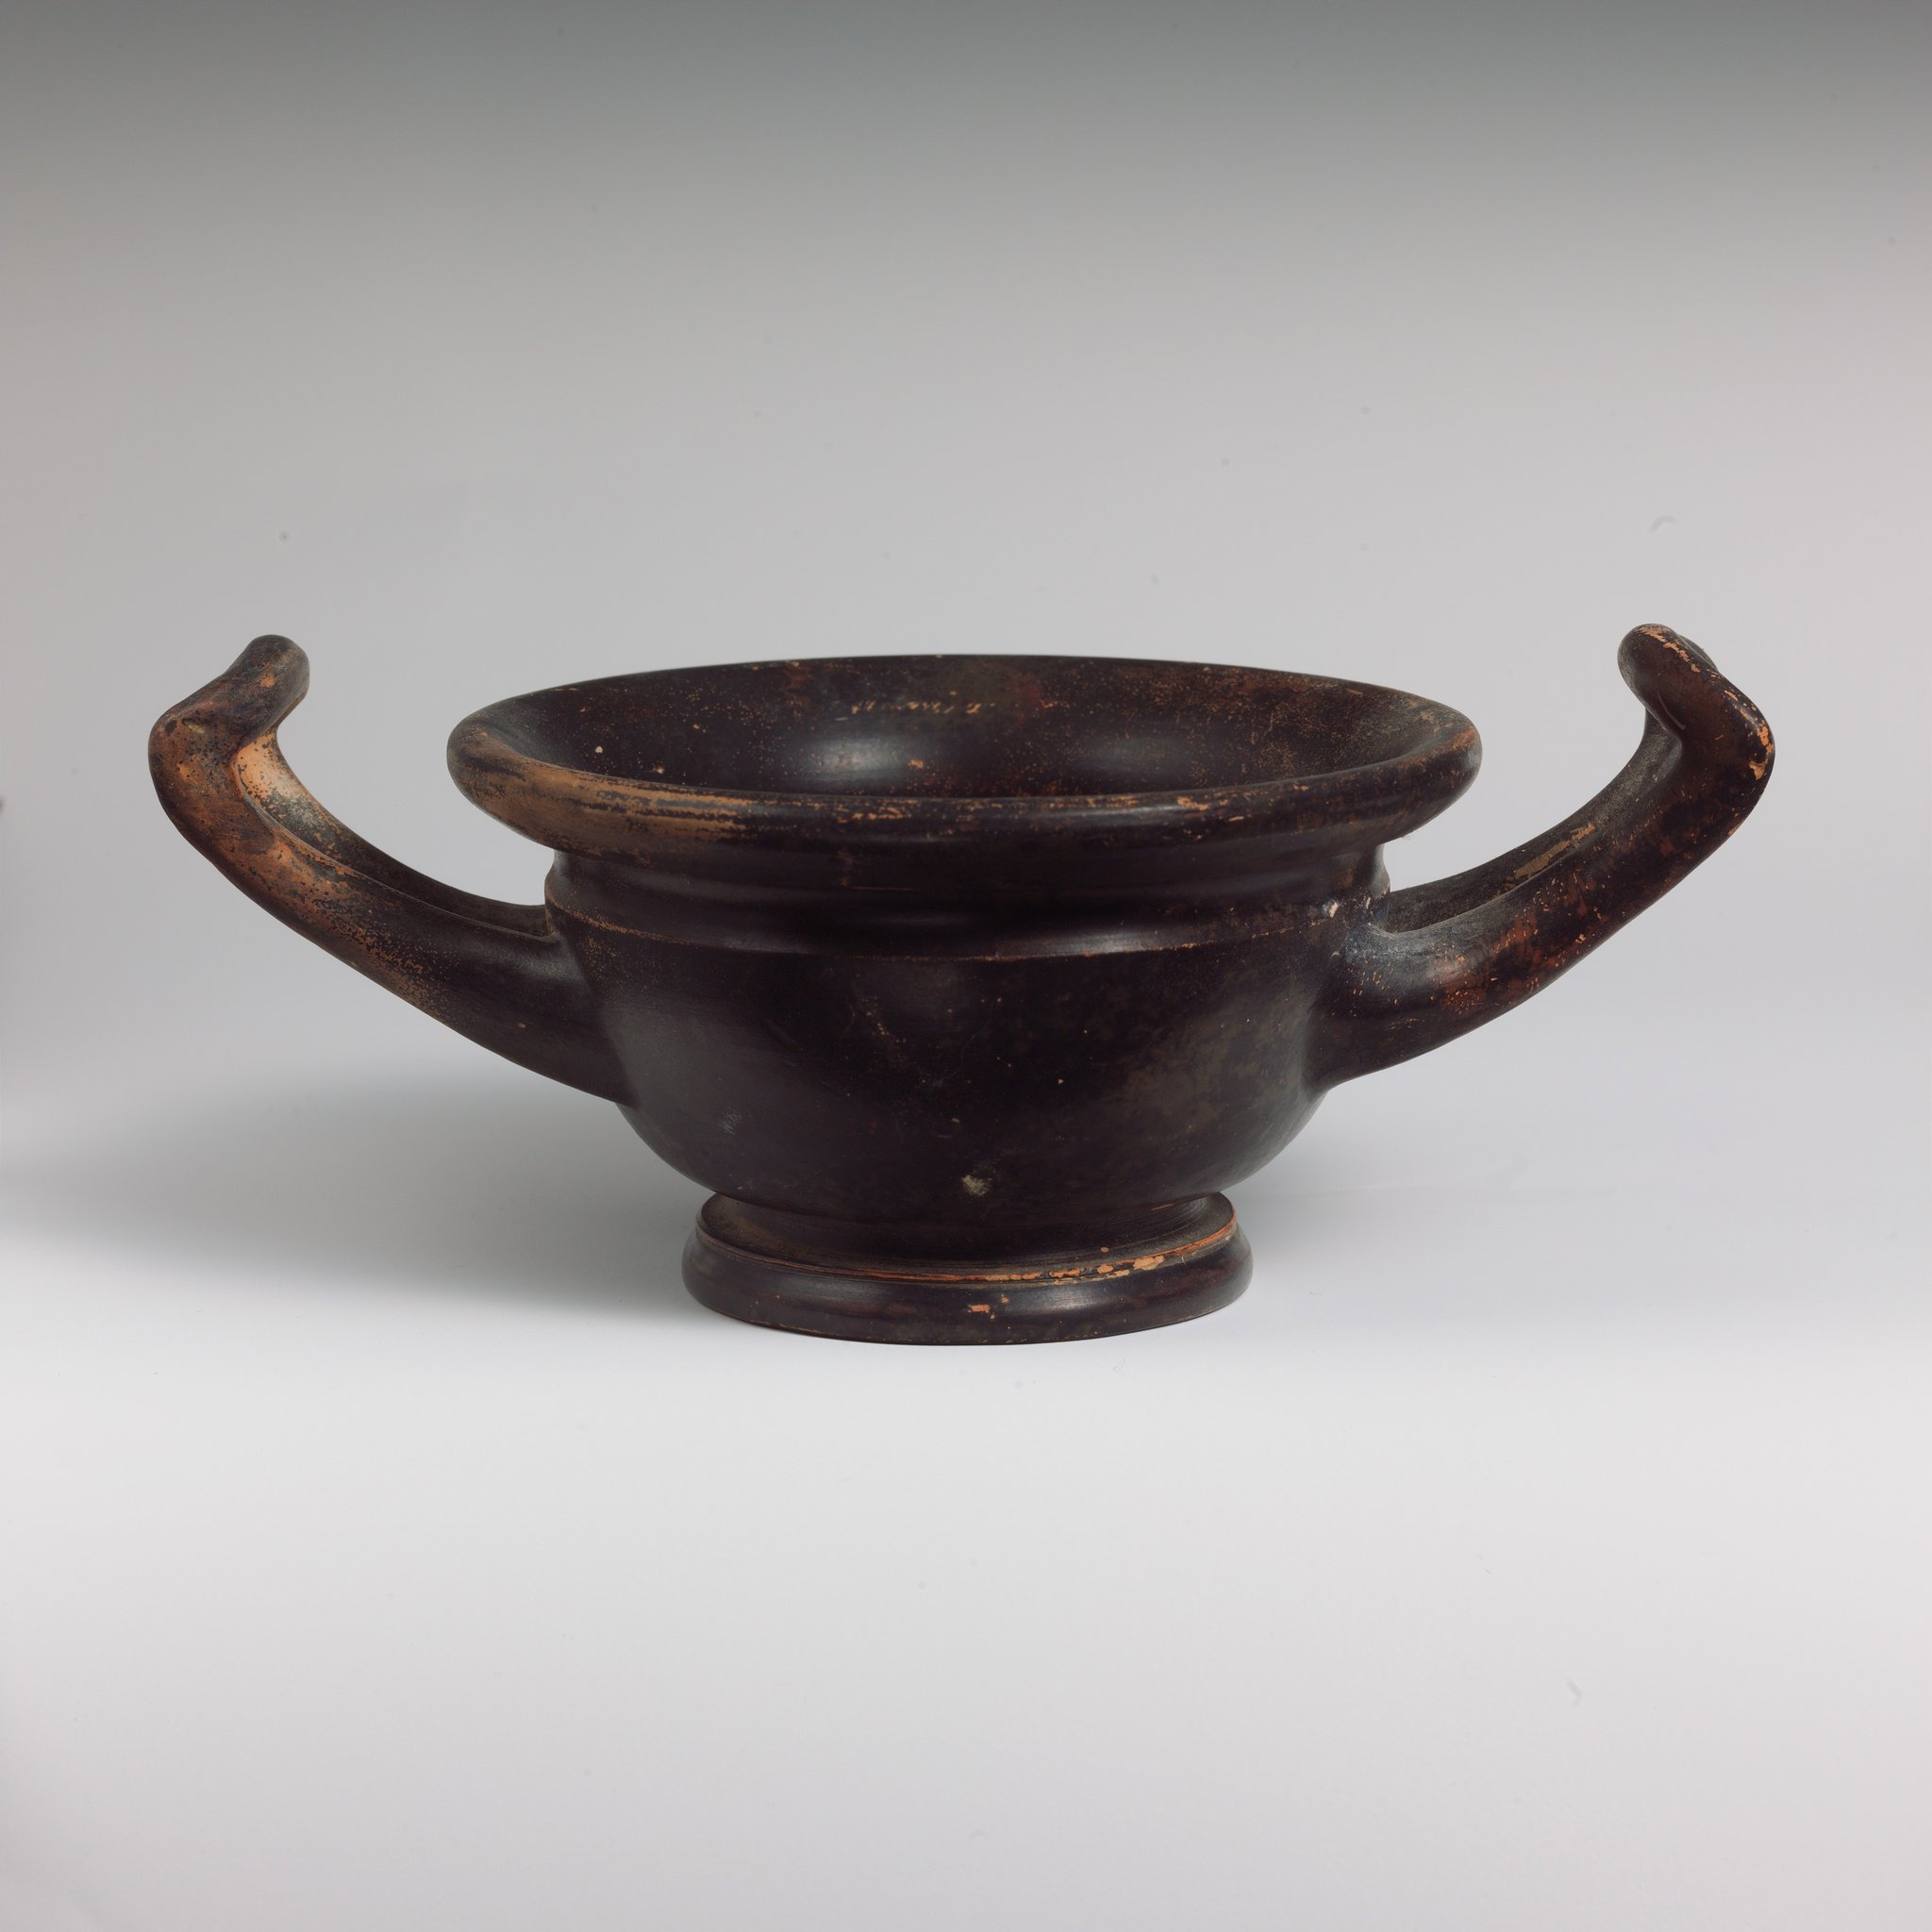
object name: cup kantharos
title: Terracotta cup-kantharos (drinking cup)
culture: greek, attic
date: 400-350 BCE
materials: terracotta